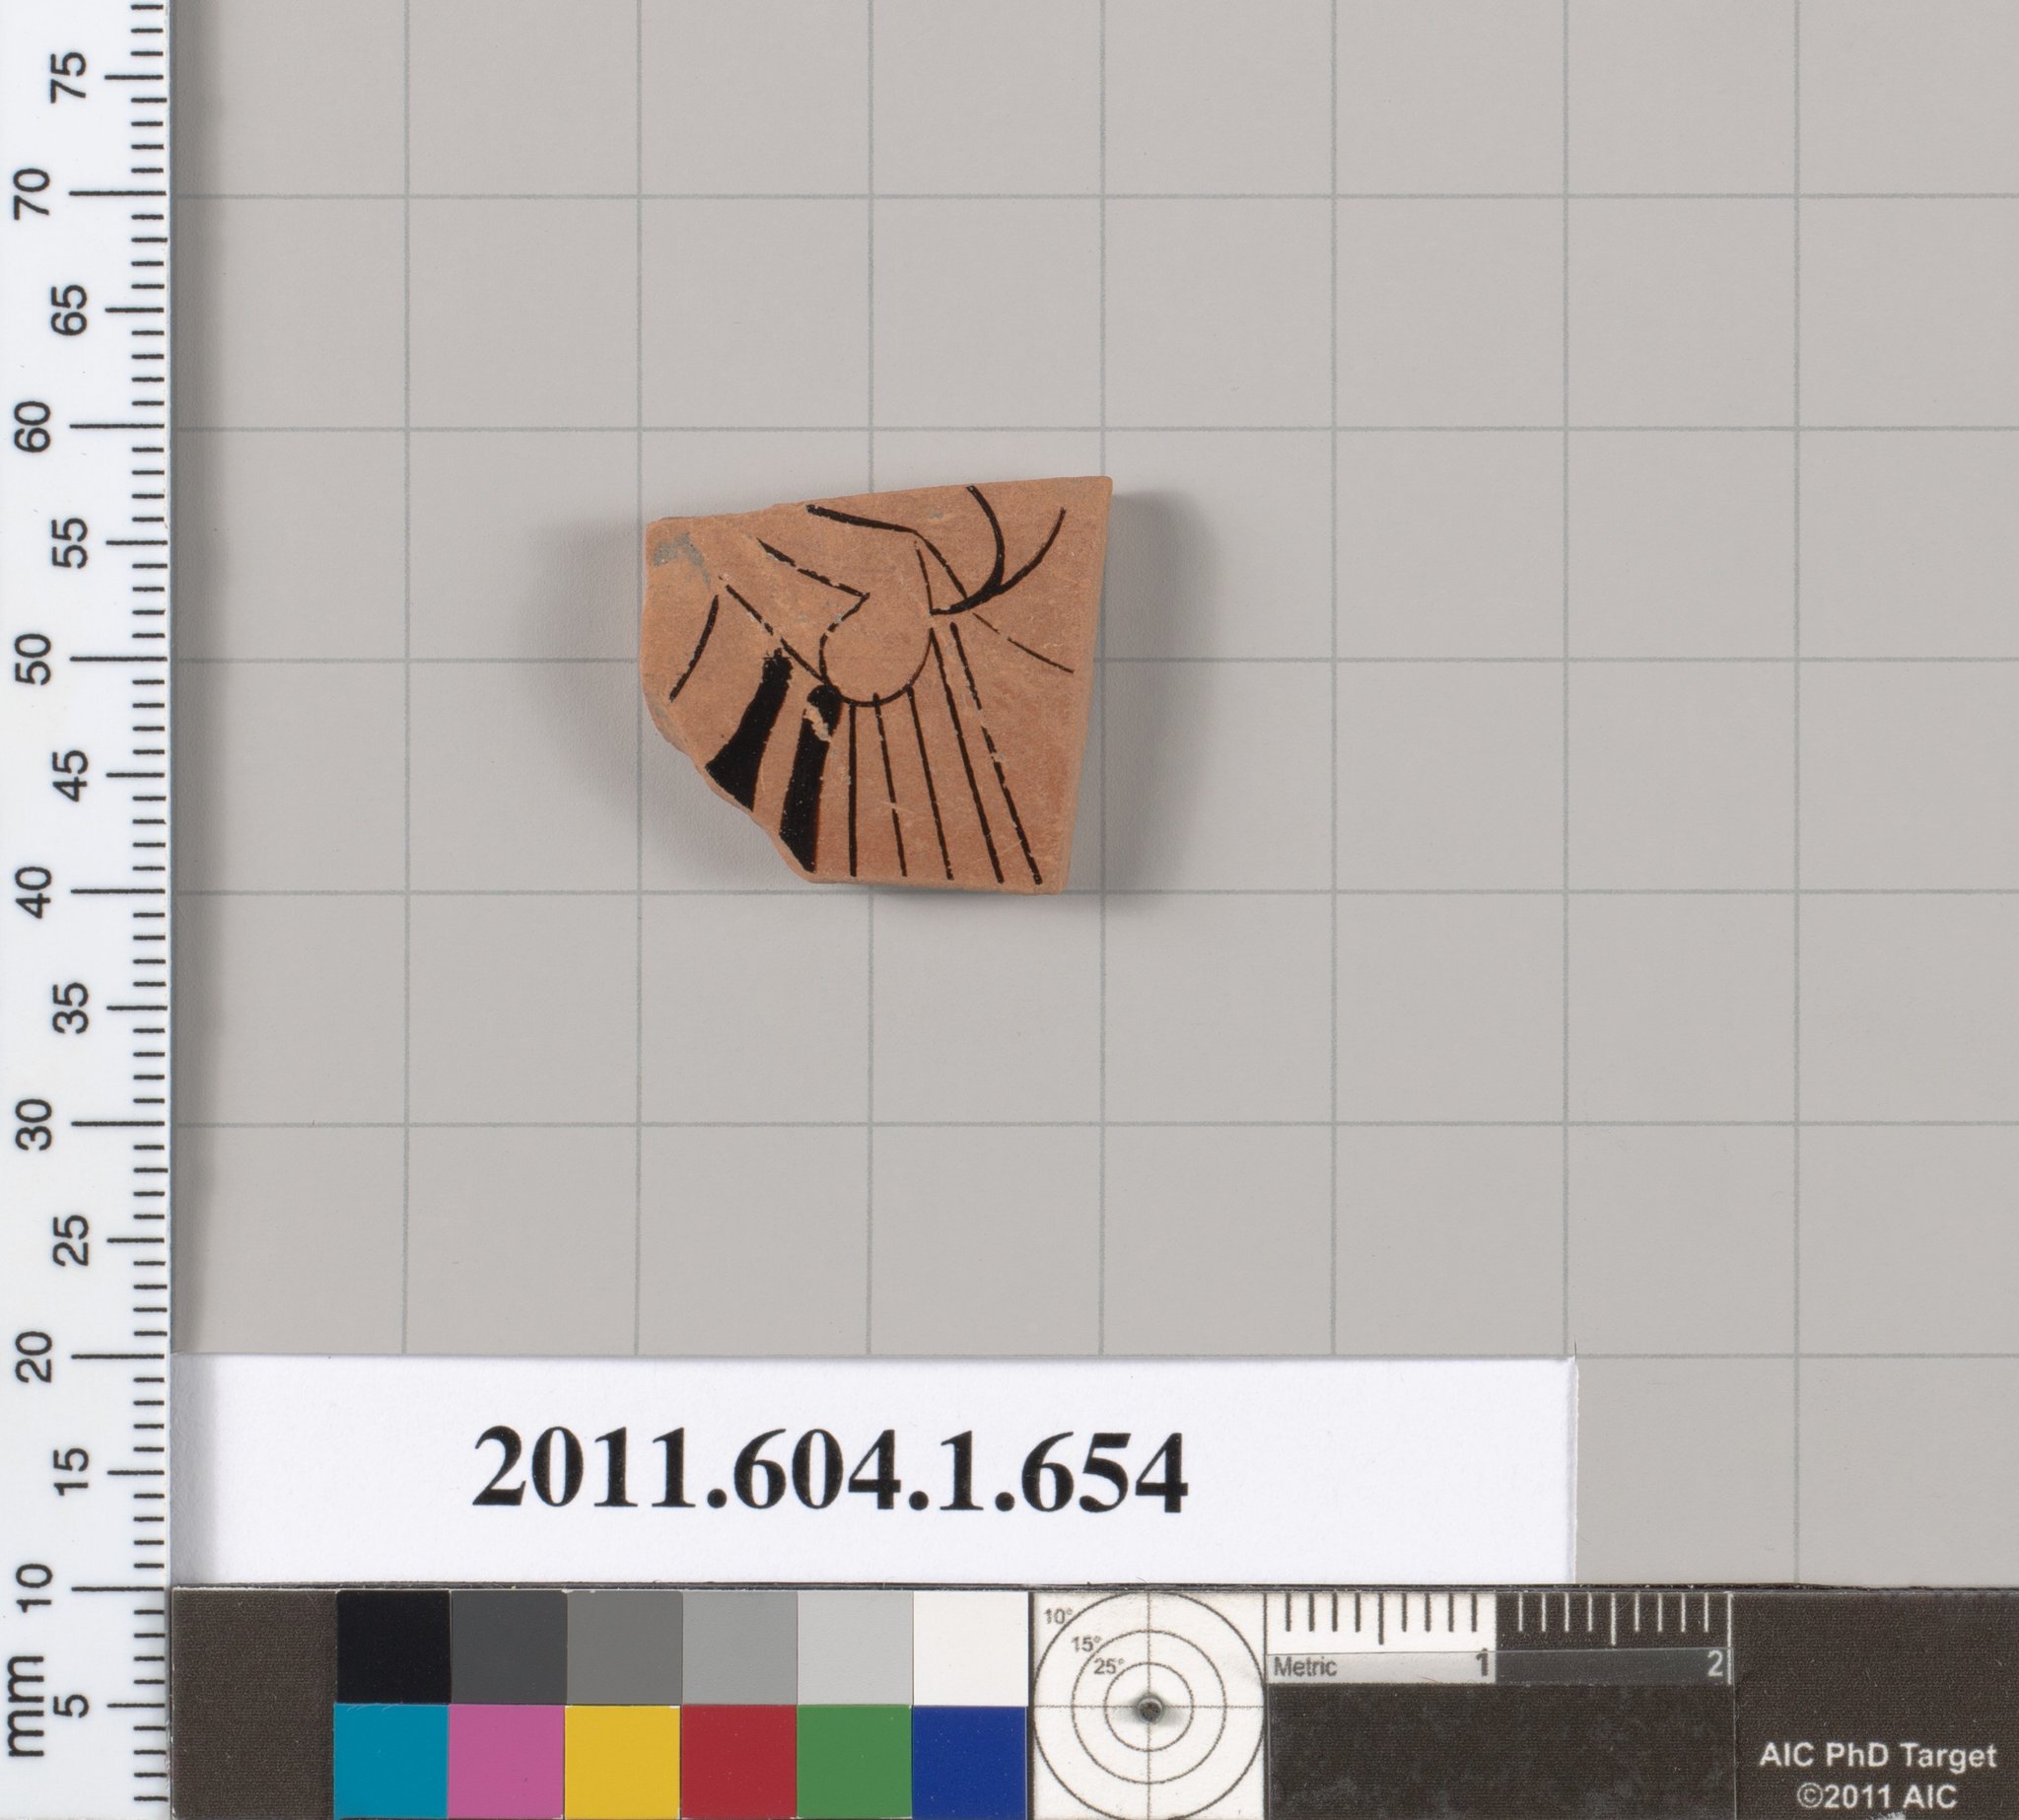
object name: kylix fragment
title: Terracotta fragment of a kylix (drinking cup)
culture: greek, attic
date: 475-451 BCE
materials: terracotta